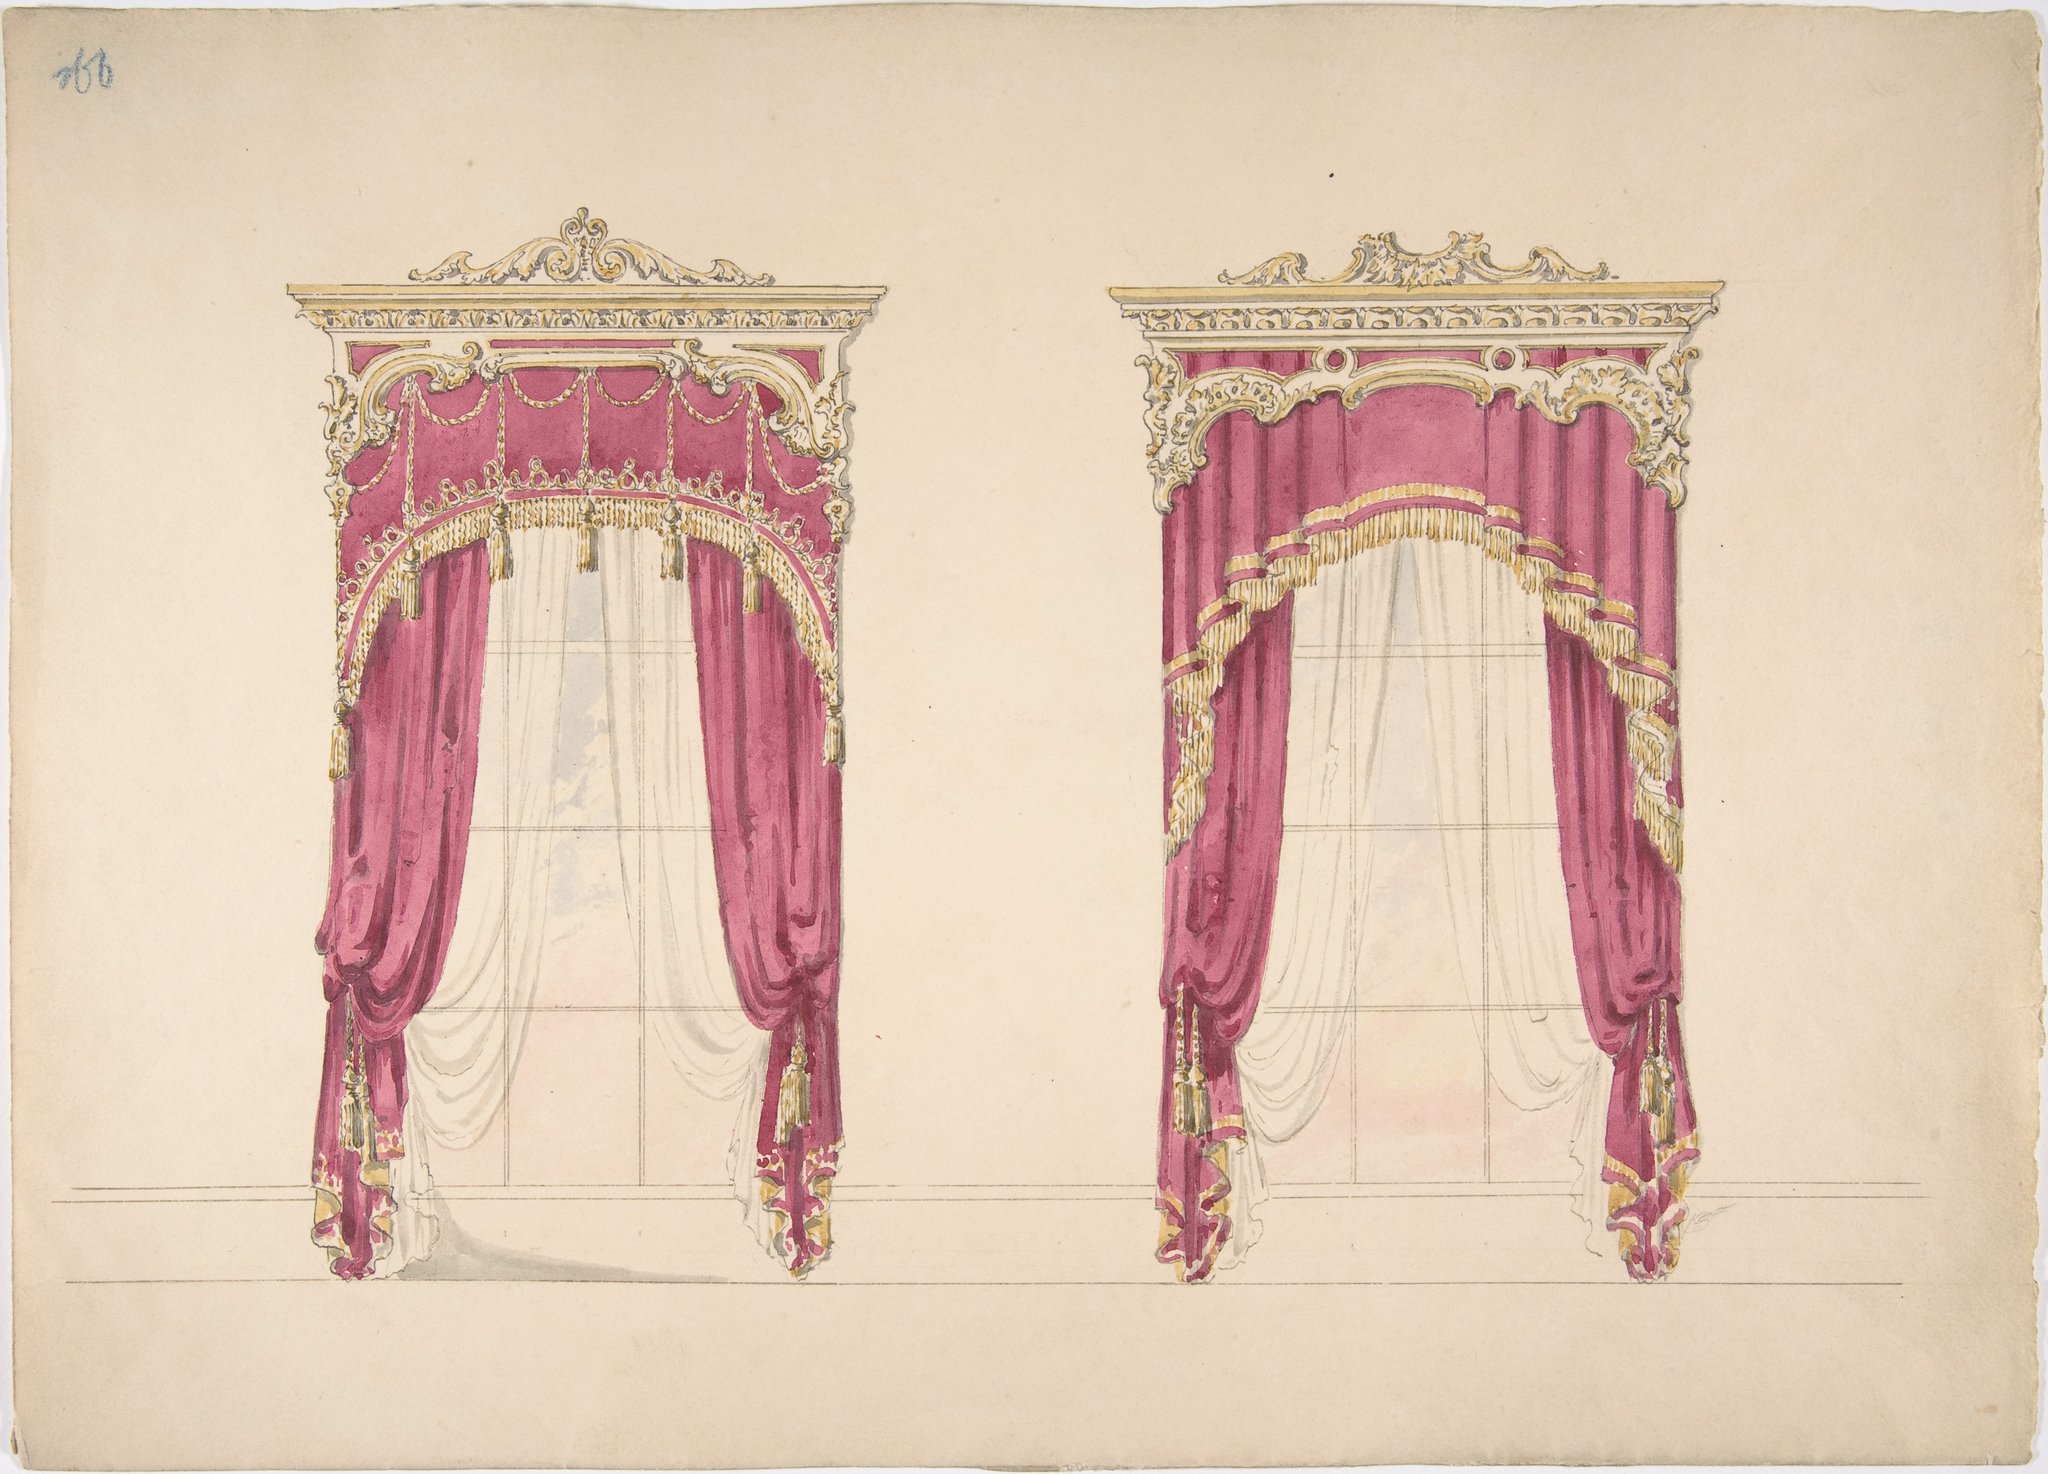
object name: drawing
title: Design for Red Curtains with Gold Fringes and a Gold and White Pediment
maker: anonymous, british, 19th century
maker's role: artist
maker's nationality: british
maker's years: 1800-1900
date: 1801-1833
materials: ink, watercolor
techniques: brush, pen, wash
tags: curtains